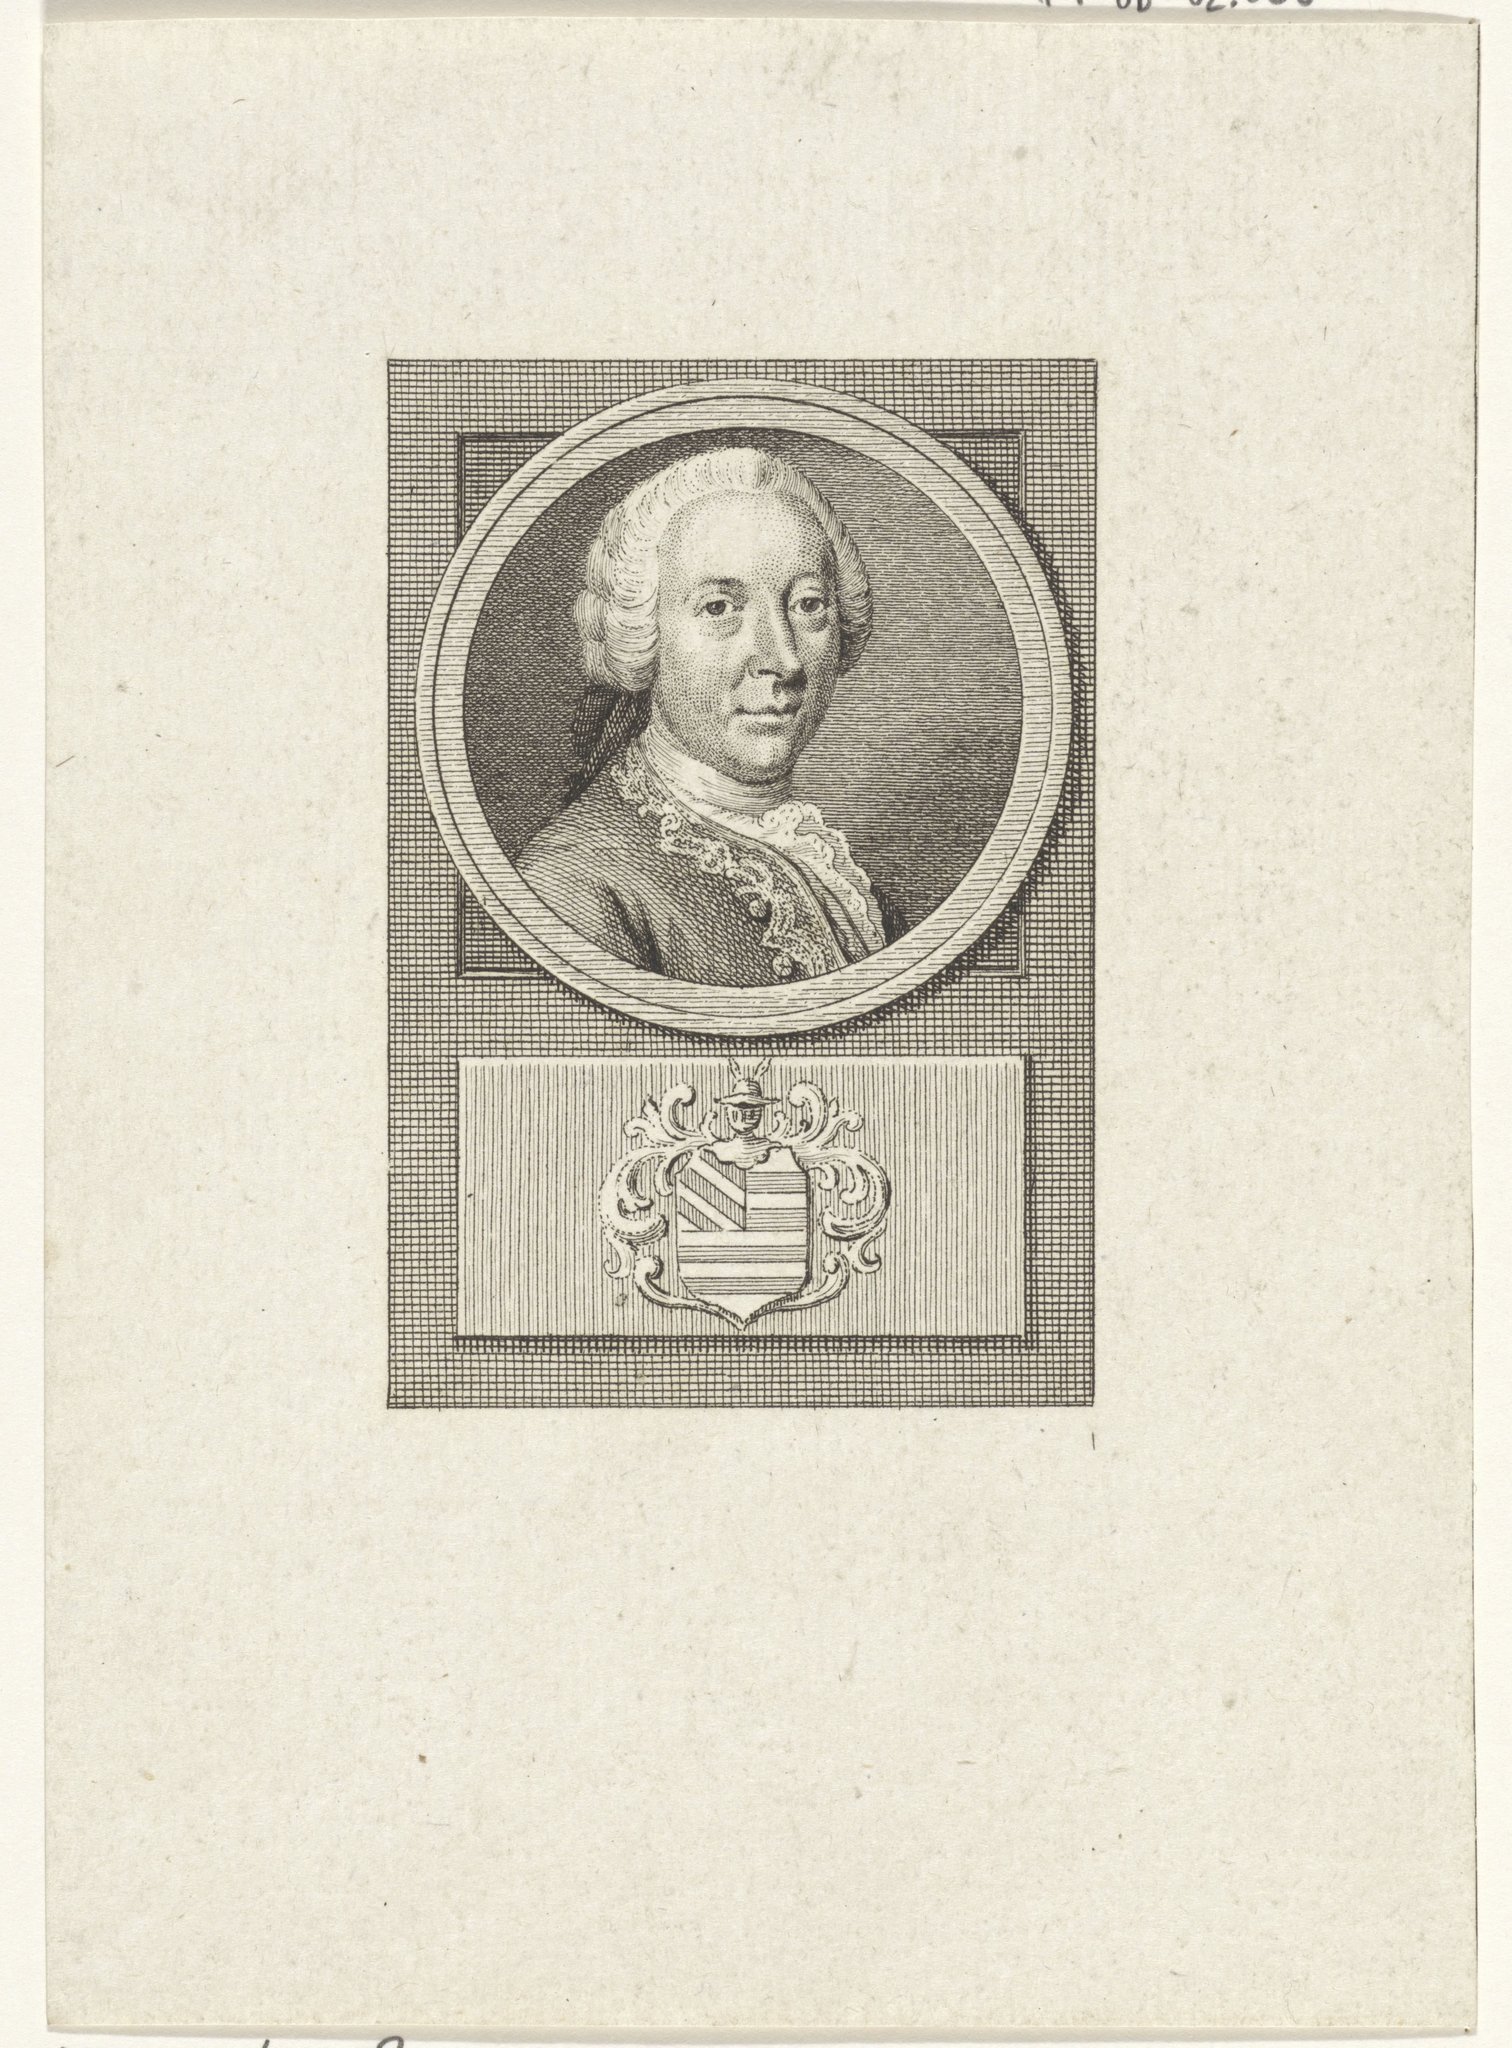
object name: print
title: Portret van Willem van Haren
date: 1783-1795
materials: paper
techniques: etching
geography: amsterdam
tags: armorial bearing, heraldry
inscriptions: collector's mark: Lugt 2228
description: Latere staat prent gebruikt in: Fokke, Jan. Geschiedenissen der Vereenigde Nederlanden voor de vaderlandsche jeugd Ie-XXVste deel. Amsterdam: Johannes Allart, 1783-1795. Deel XIII.